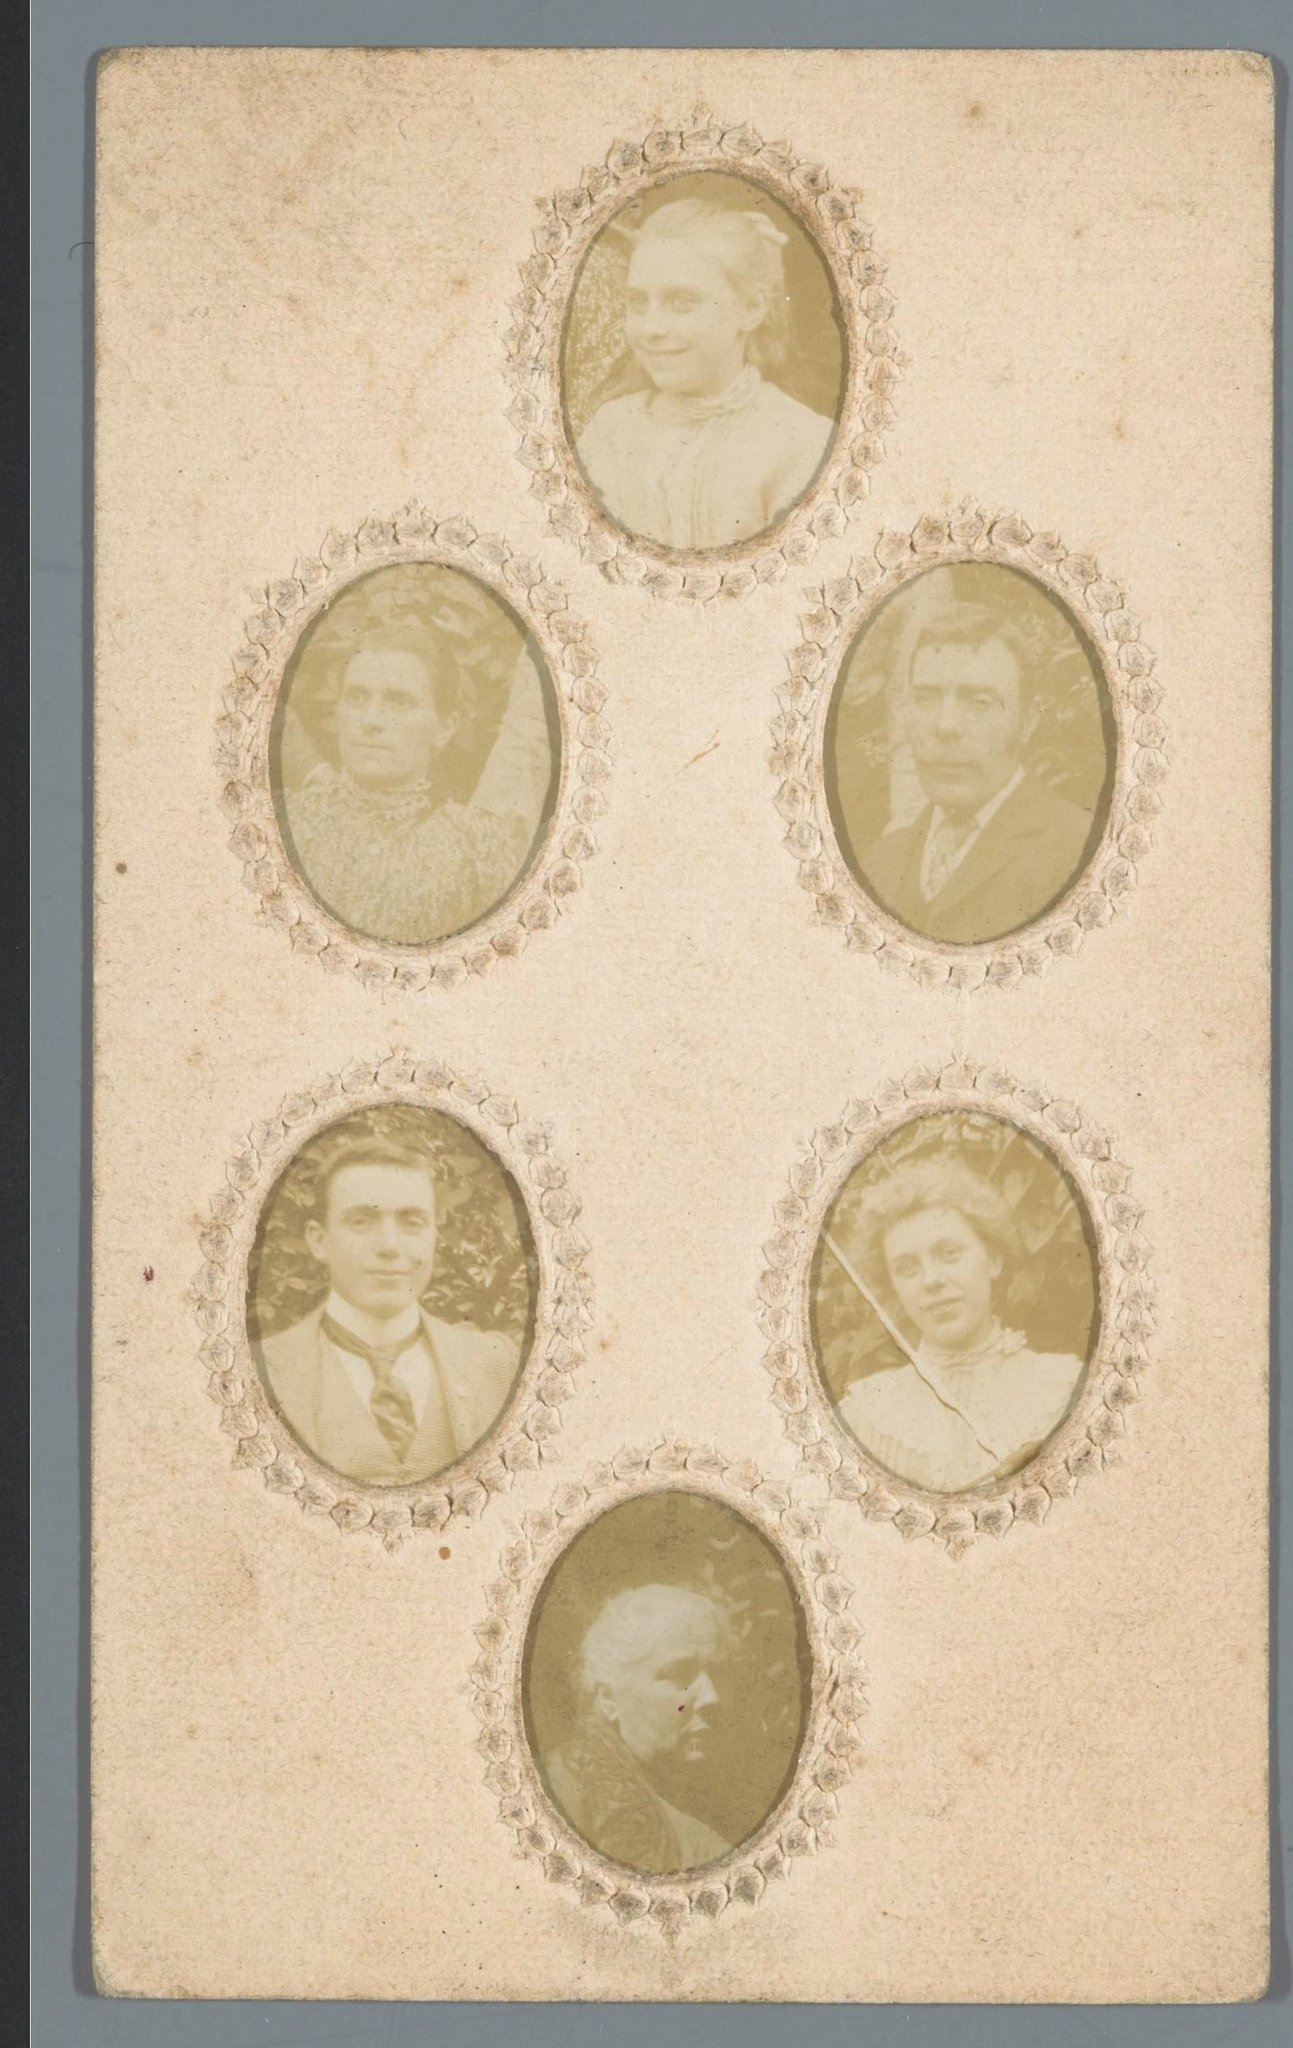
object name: carte de visite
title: Zes miniatuurportretten van onbekende mannen en vrouwen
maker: john george kirby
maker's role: fotograaf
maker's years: 1849-1913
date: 1870-1880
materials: cardboard, paper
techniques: albumen print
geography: london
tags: historical persons - bb - woman, adult man, historical persons, youth, adolescent, old woman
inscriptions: inscription: ‘J. G. KIRBY,/ Photographey/ 295, Edgware Road, London, W./ PRICES/ (...)’